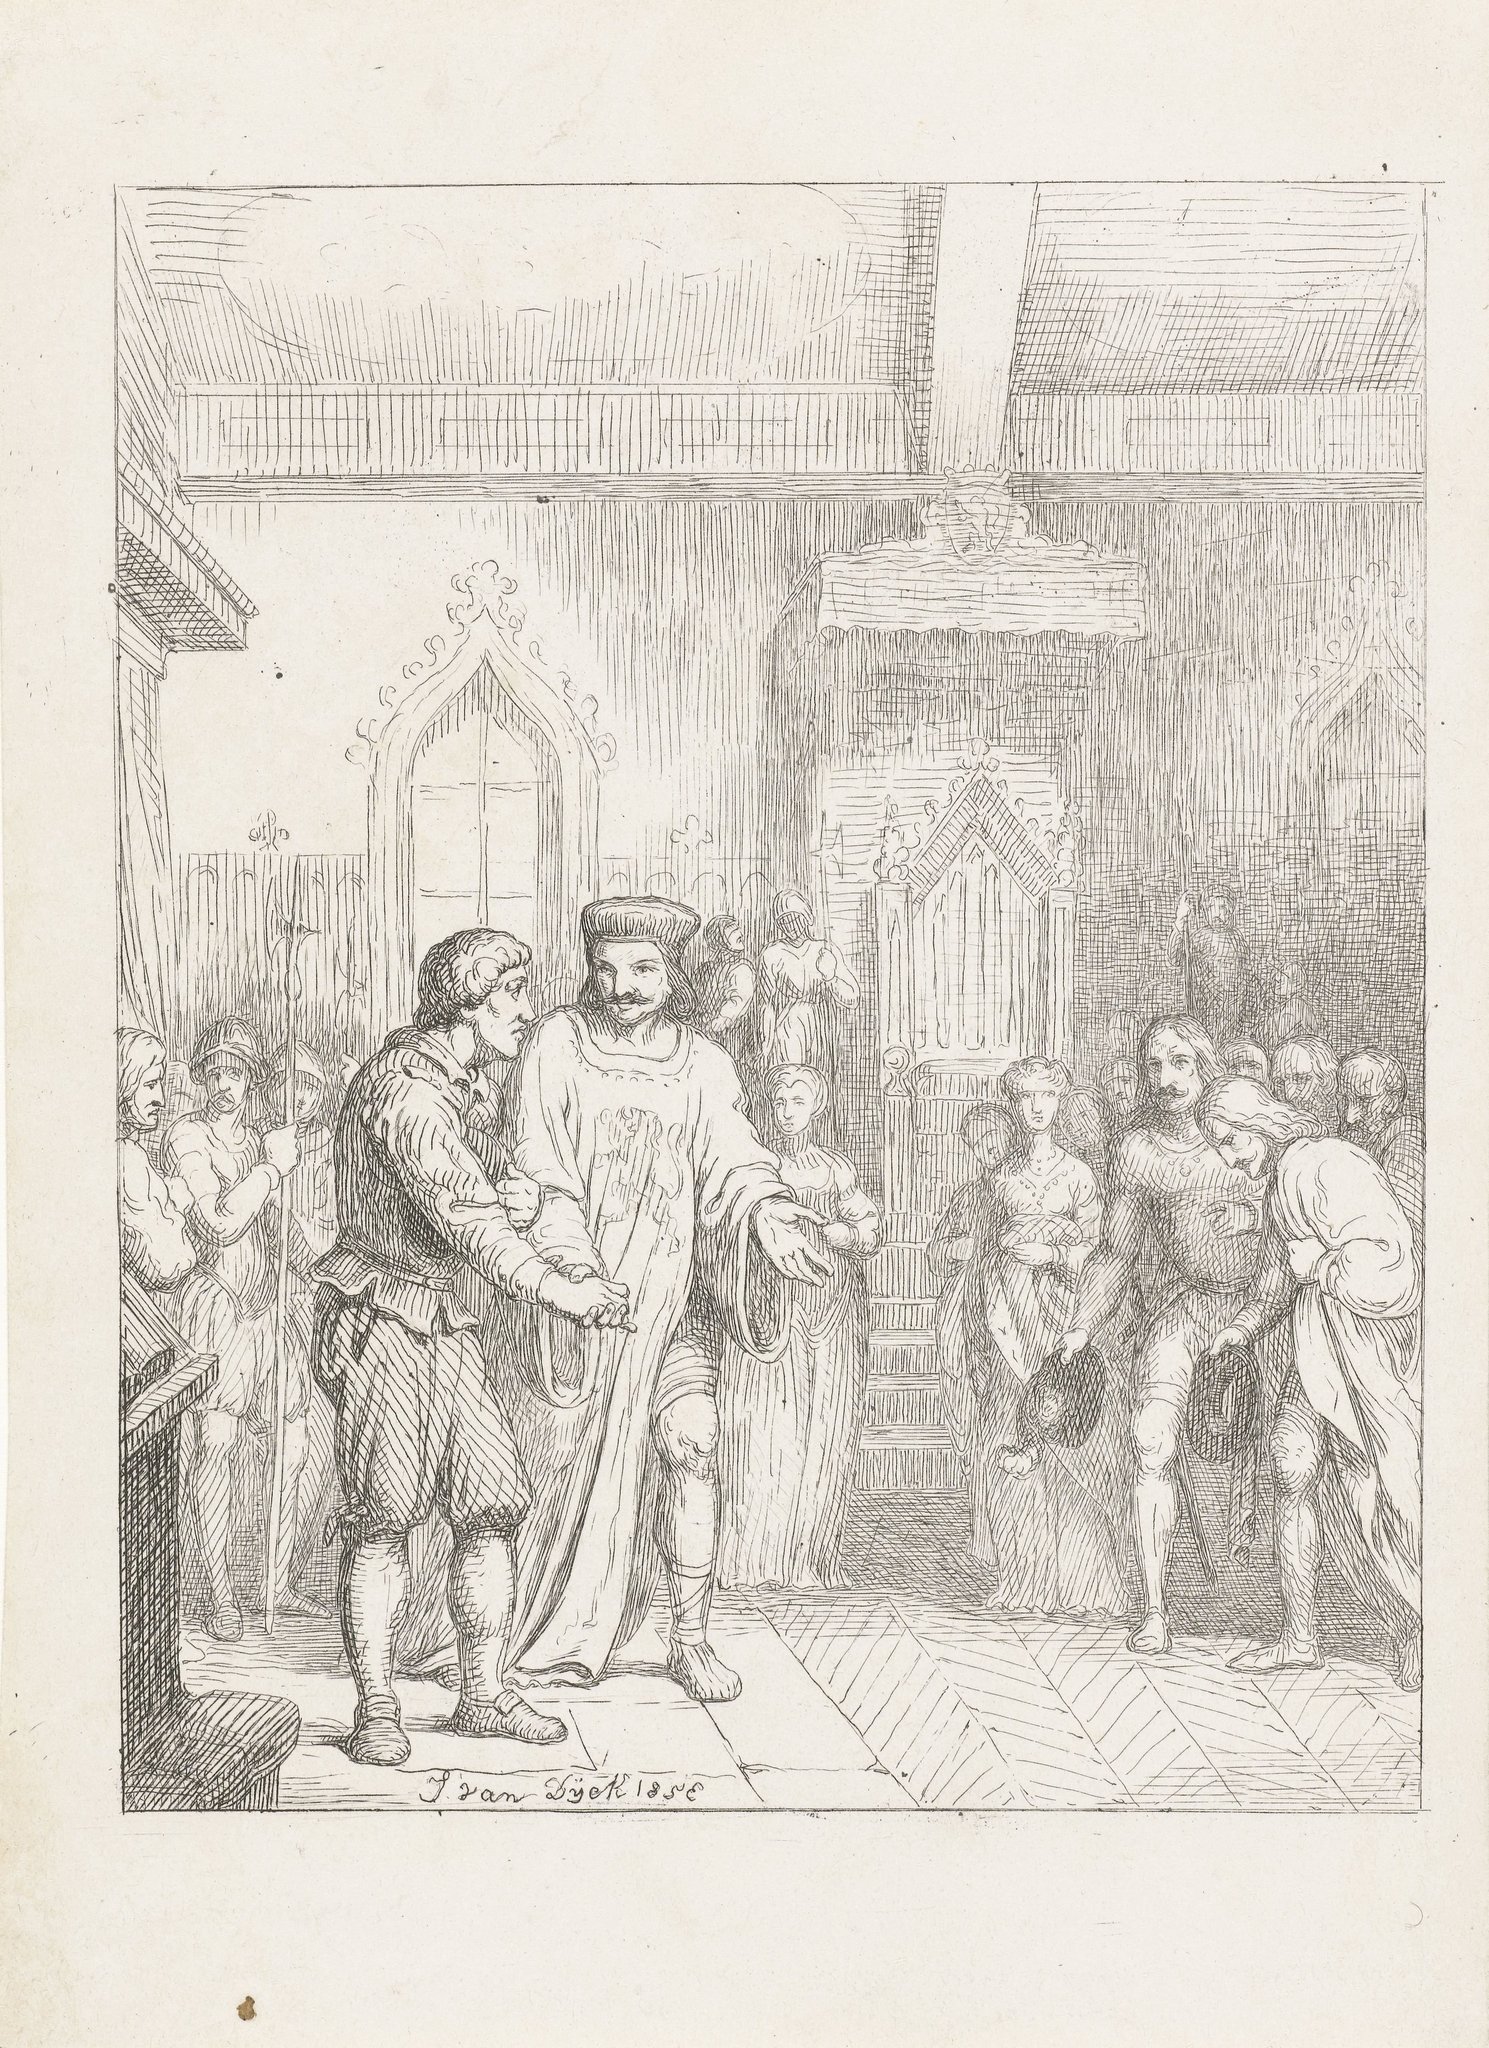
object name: print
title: Boudewijn graaf van Vlaanderen en boer Cnillis reiken elkaar de hand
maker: jacobus van dijck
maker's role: print maker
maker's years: 1817-1896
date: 1853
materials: paper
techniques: etching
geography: netherlands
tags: farmers, emperor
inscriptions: collector's mark: Lugt 2228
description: Boudewijn graaf van Vlaanderen en boer Cnillis reiken elkaar de hand voor de ogen van het gehele hof. Illustratie voor het verhaal De dorschvlegel van J.J. van der Horst.